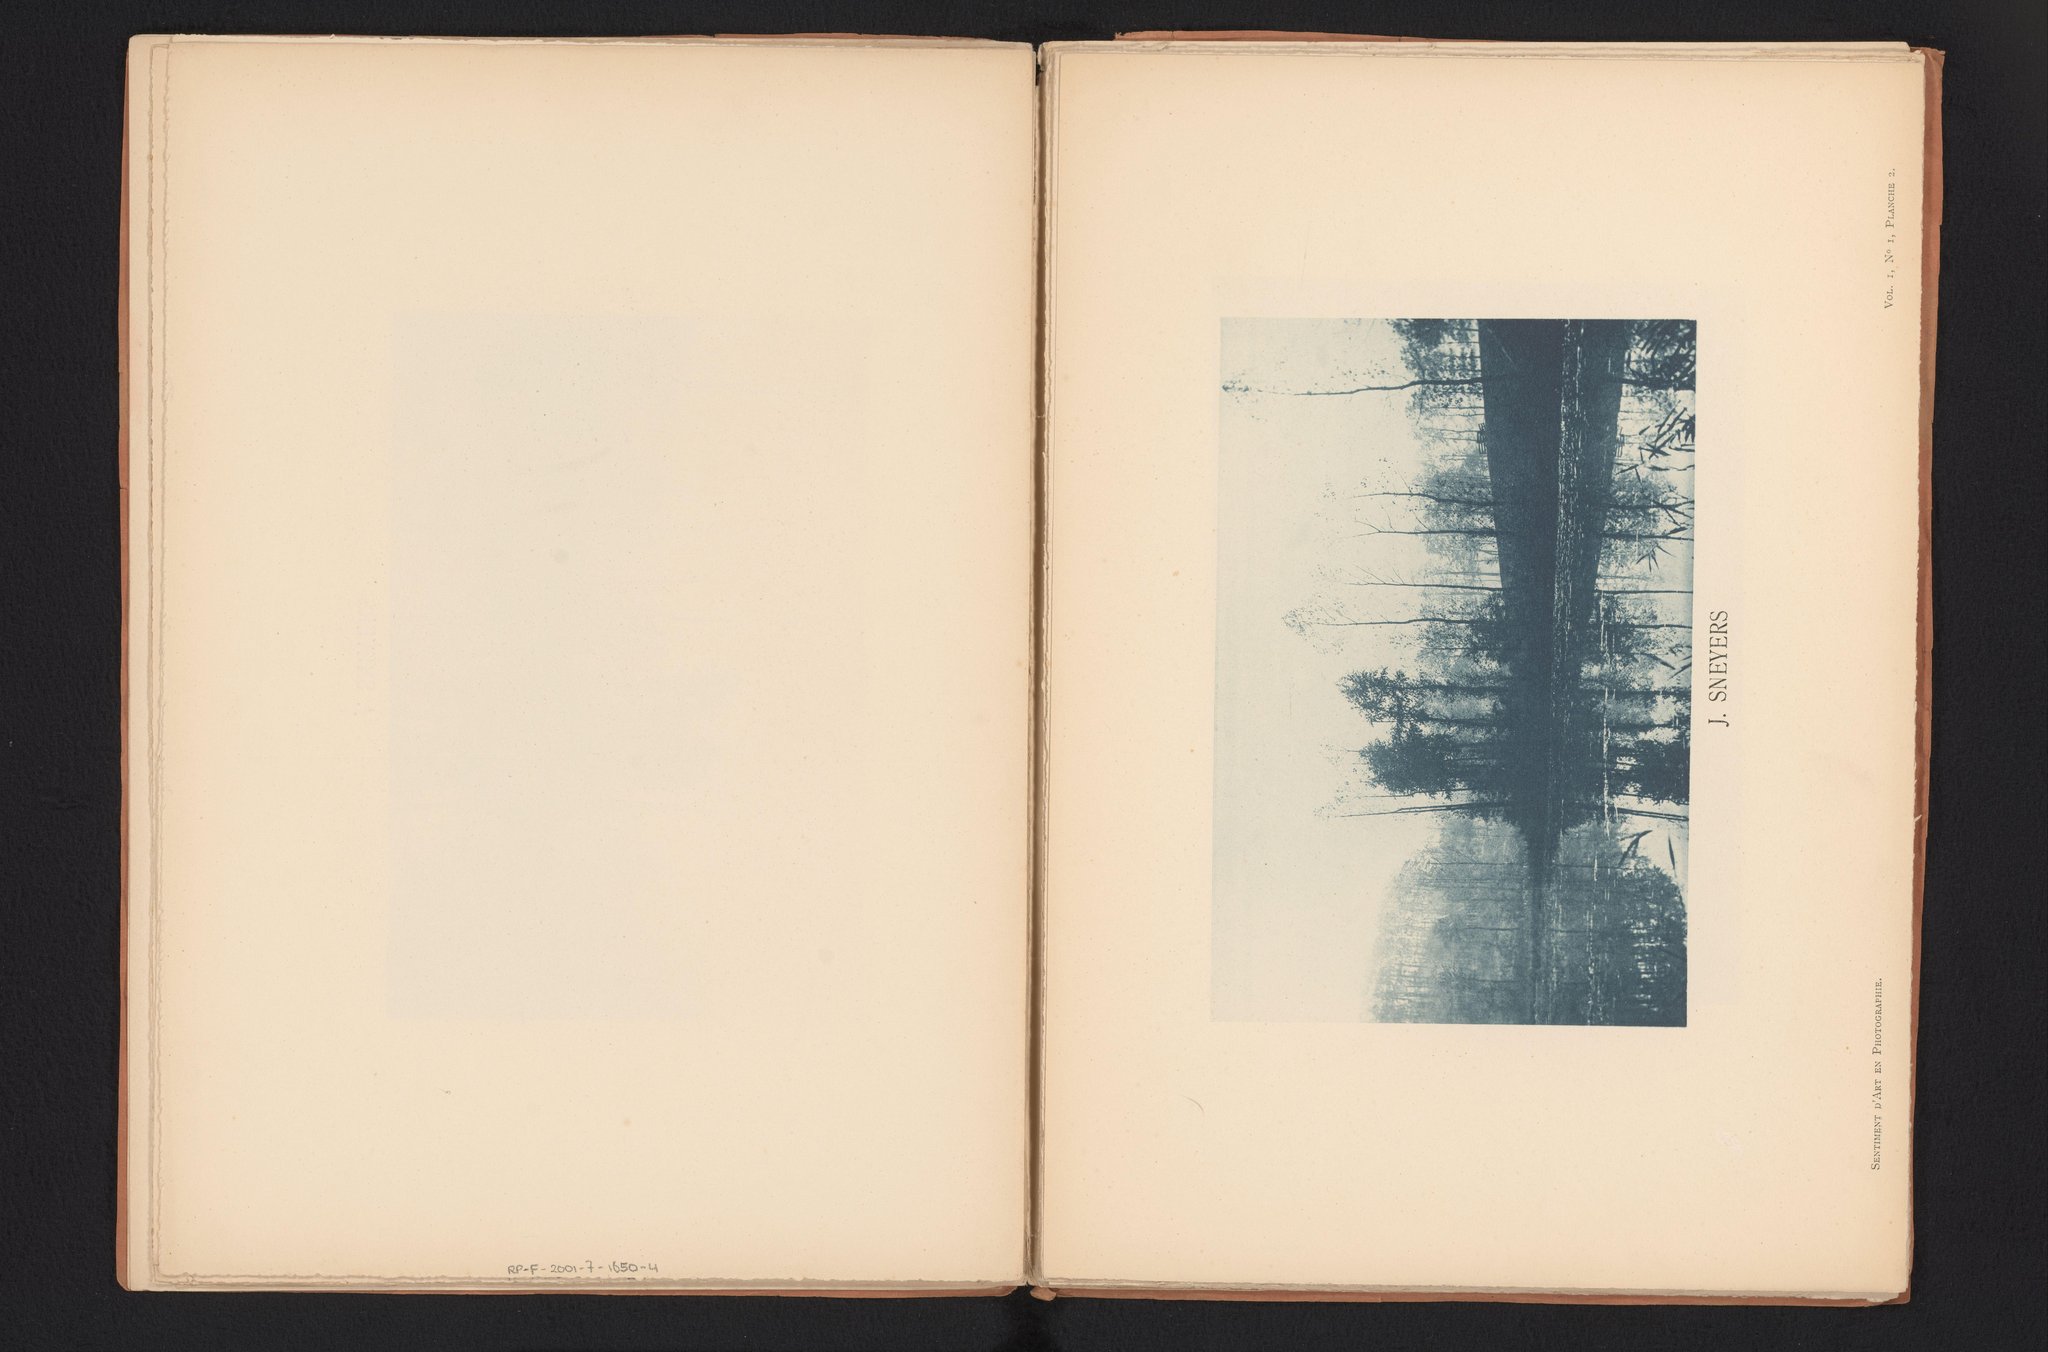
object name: photomechanical print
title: Landschap met waterpartij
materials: paper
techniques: photograph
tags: water course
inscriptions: number: ‘Vol. 1, No 1, Planche 2.’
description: Deze prent maakt deel uit van 8 omslagen met 22 tekstbladen en 89 prenten op losse bladen in en tussen de omslagen.